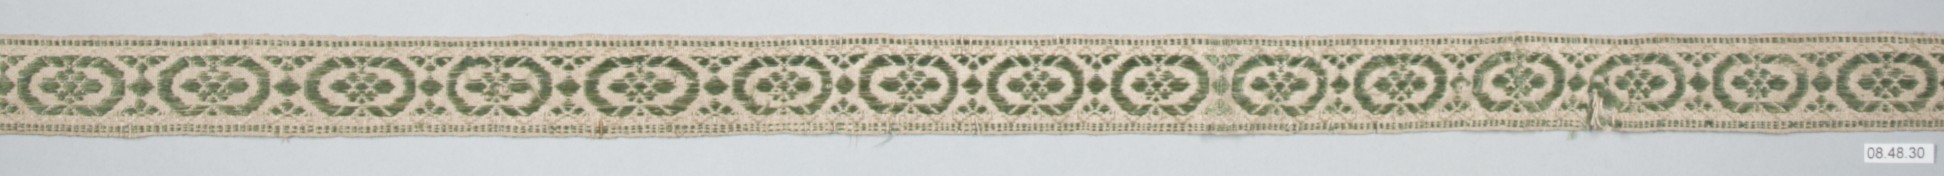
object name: galloon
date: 1701-1800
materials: silk